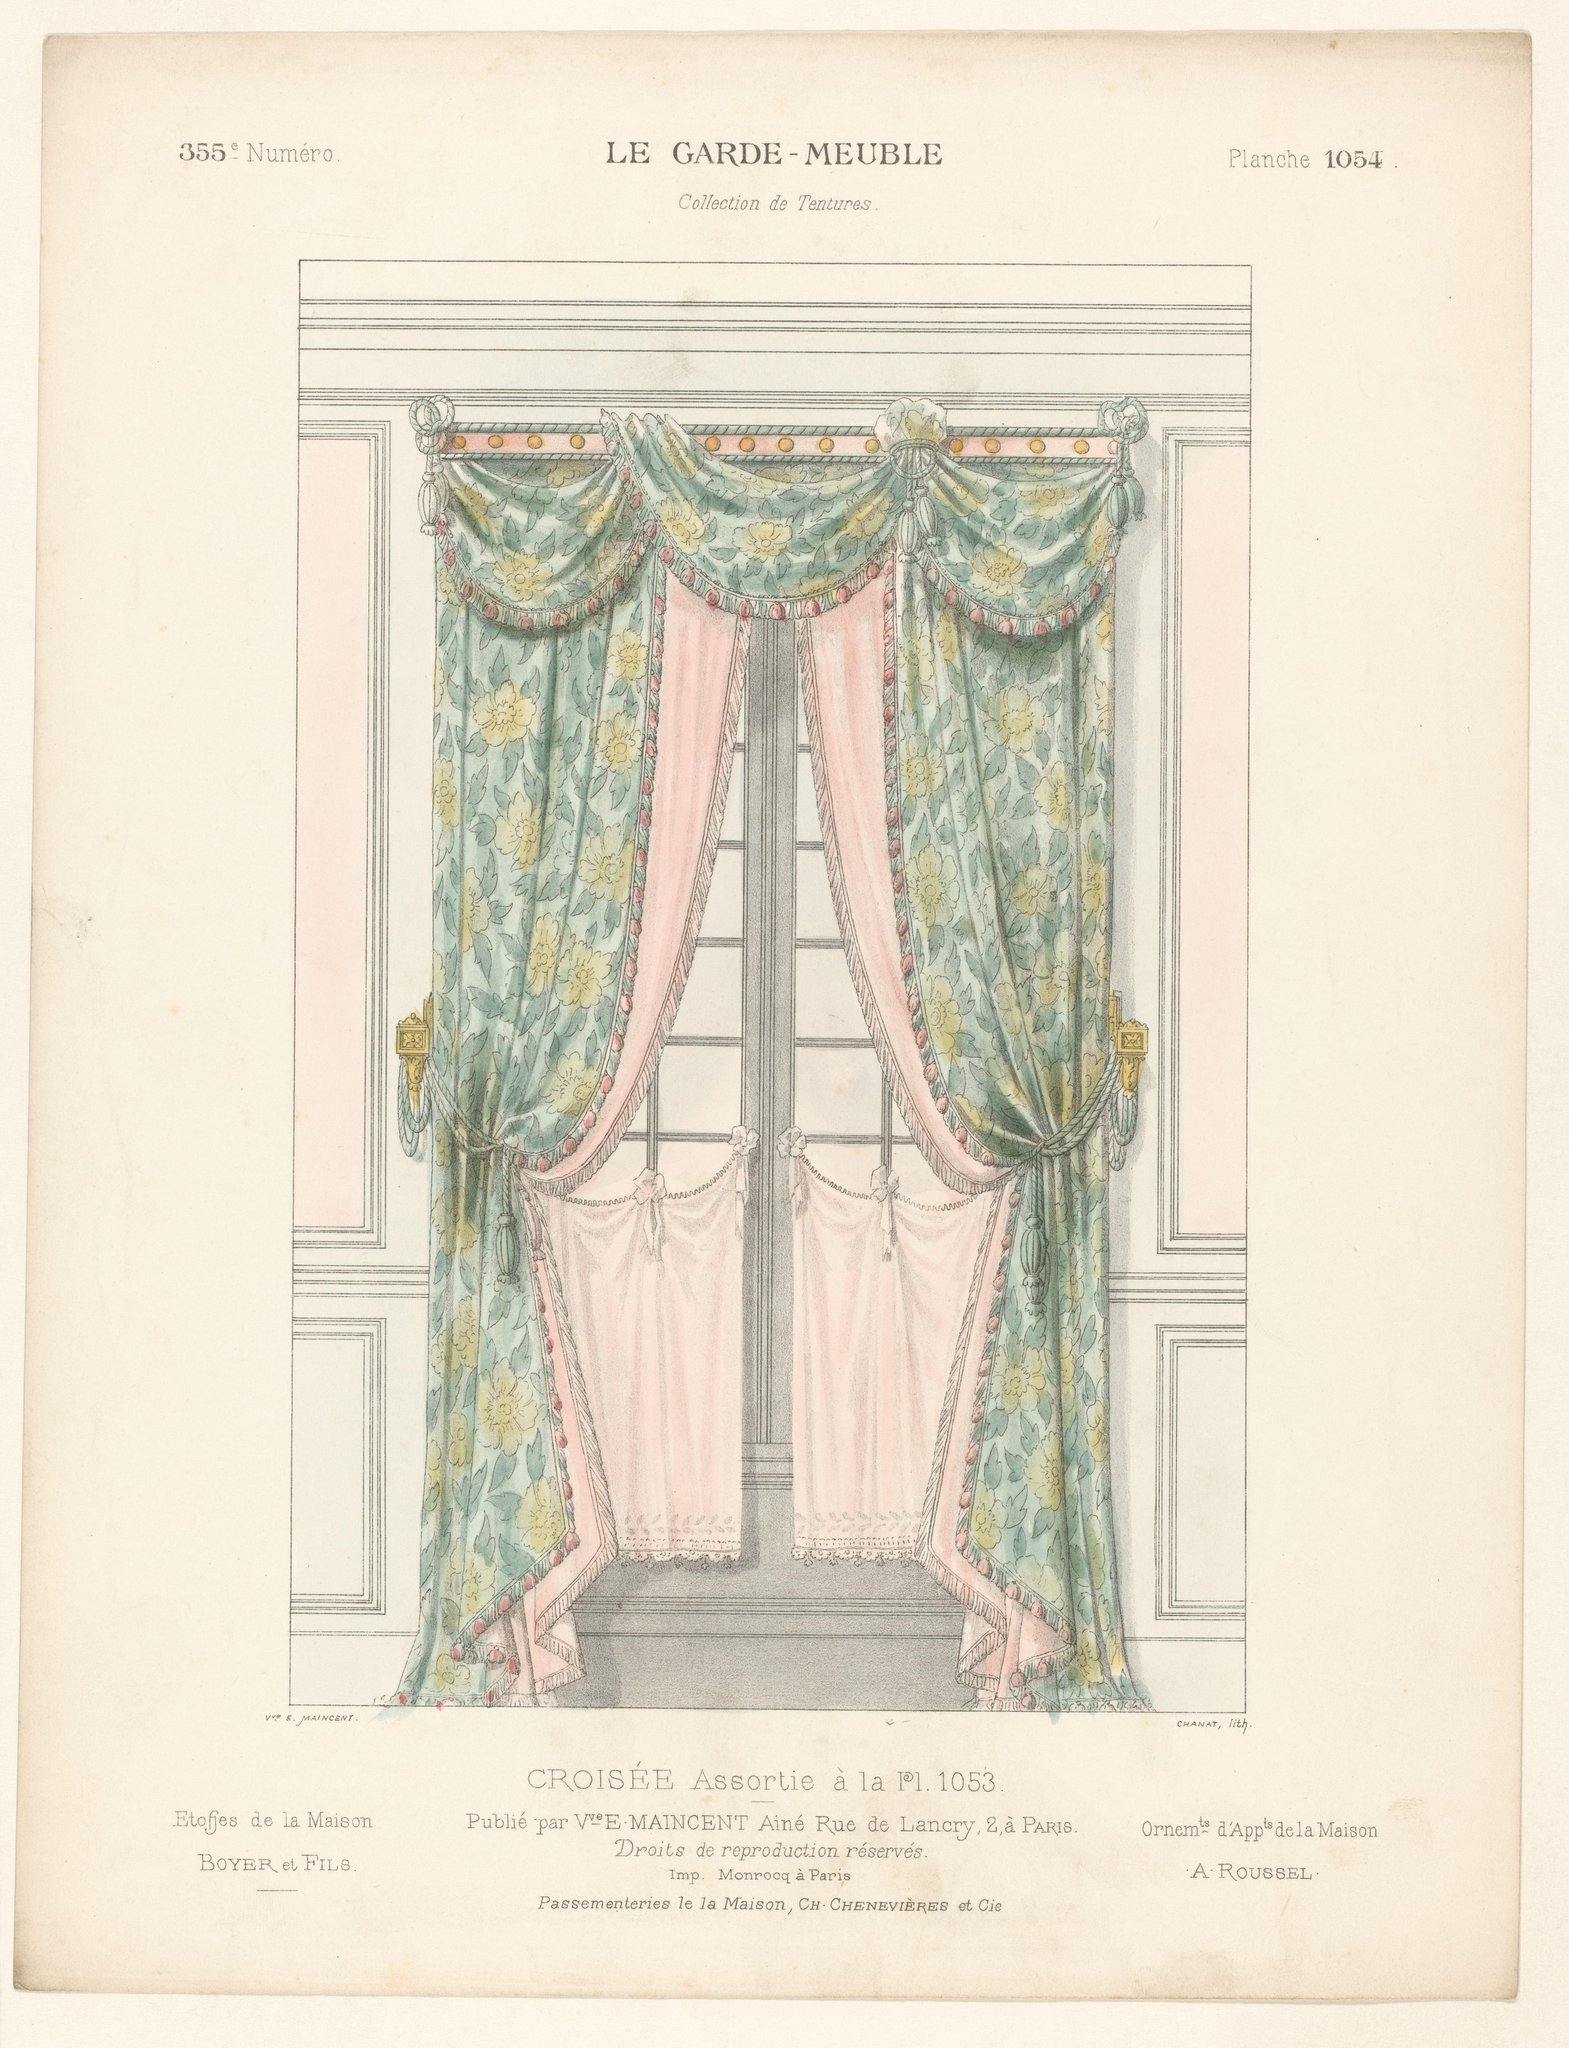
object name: print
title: Croisée Assortie à la Pl. 1053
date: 1895-1910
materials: paper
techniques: hand coloring, lithograph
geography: paris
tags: window, hangings and drapery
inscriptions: : ‘Droits de reproduction réservés.’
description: Kruisvenster met gedrapeerde gordijnen, passend bij serienr. 1053. Prent uit 355e Livraison.